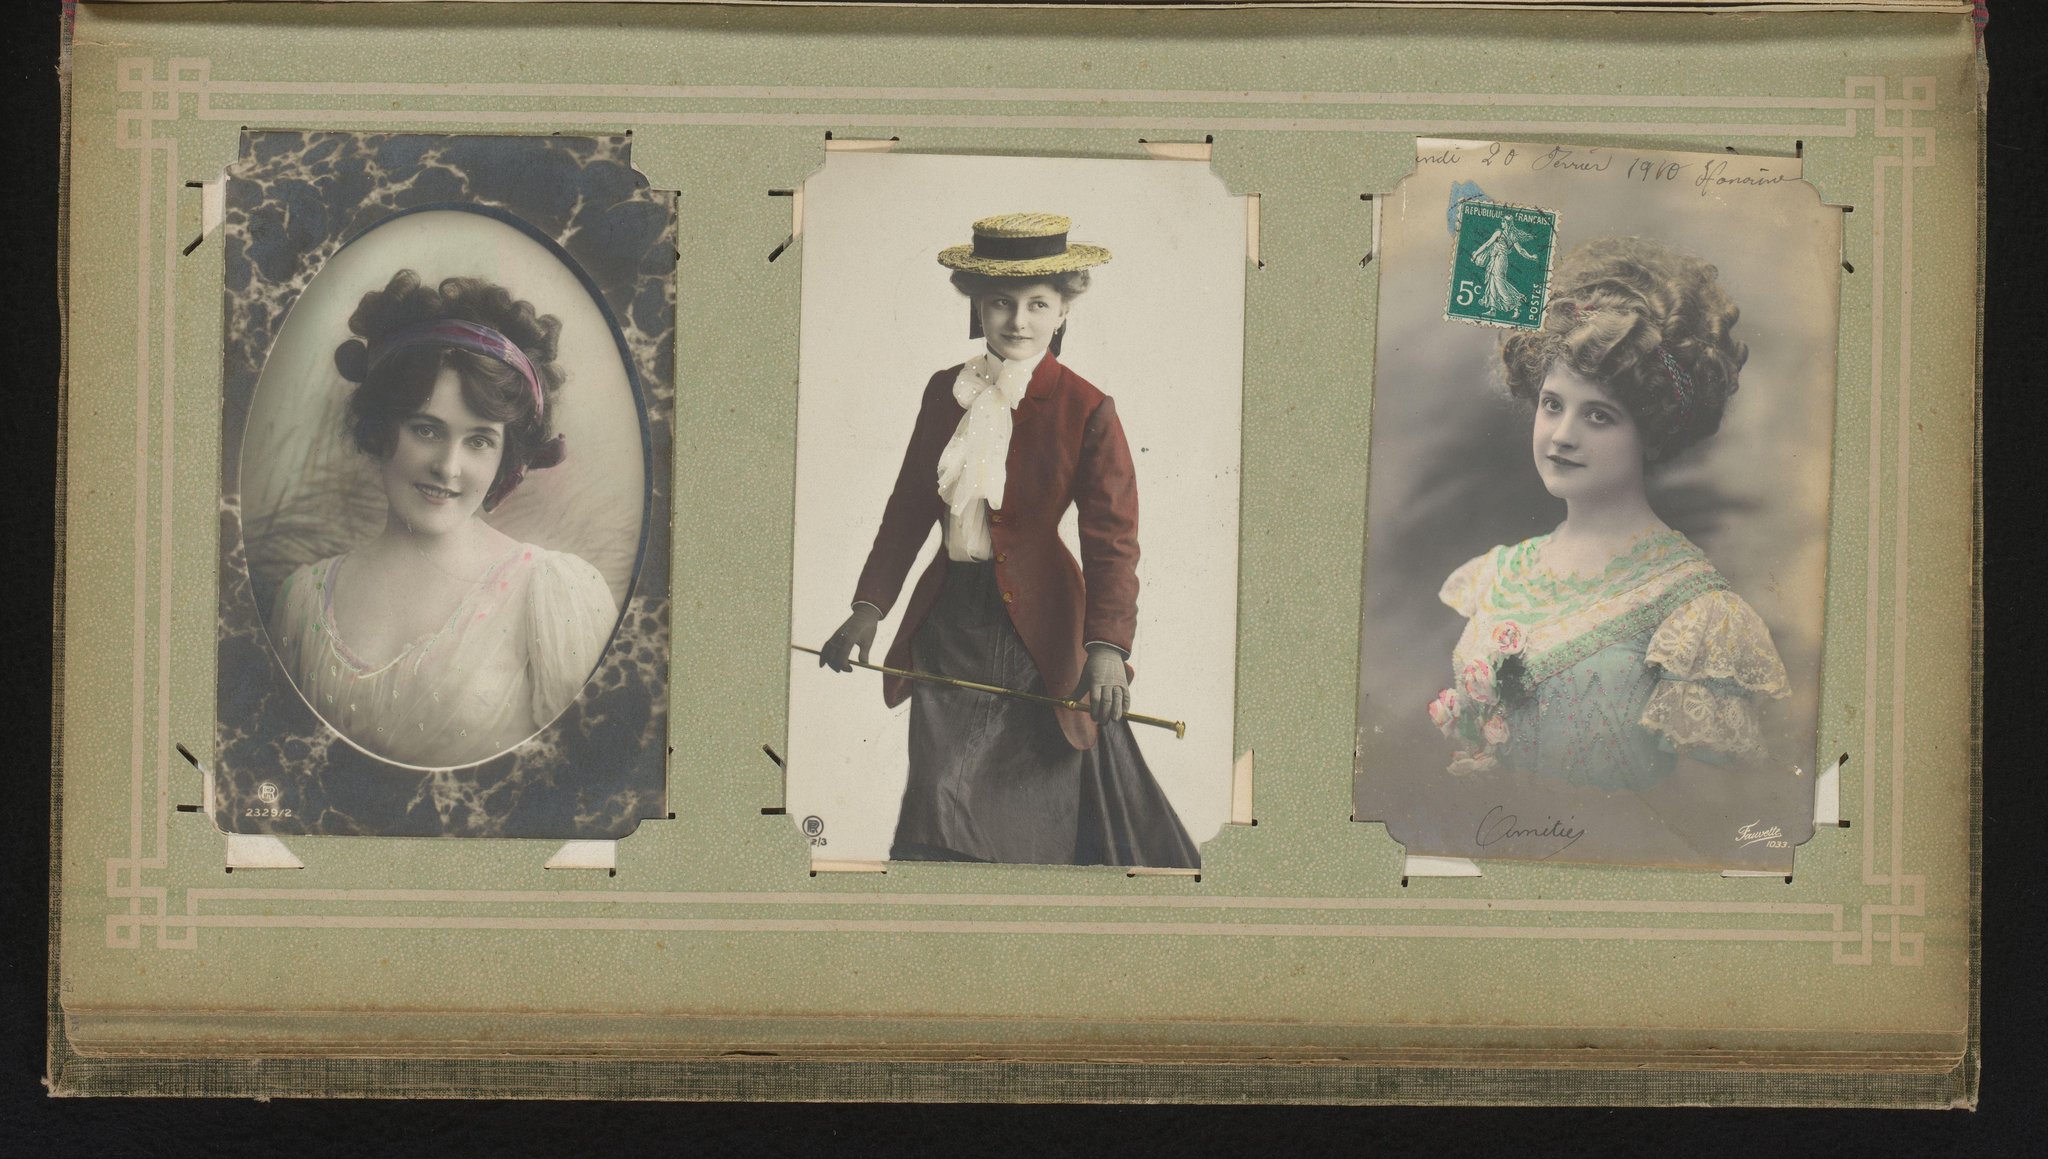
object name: album leaf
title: Drie portretten van vrouwen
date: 1900-1930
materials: cardboard, ink, photographic support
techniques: gelatin silver print, hand coloring, pen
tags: historical persons - bb - woman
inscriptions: monogram: ‘R/ P/ H’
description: Deze foto's maken deel uit van een album.